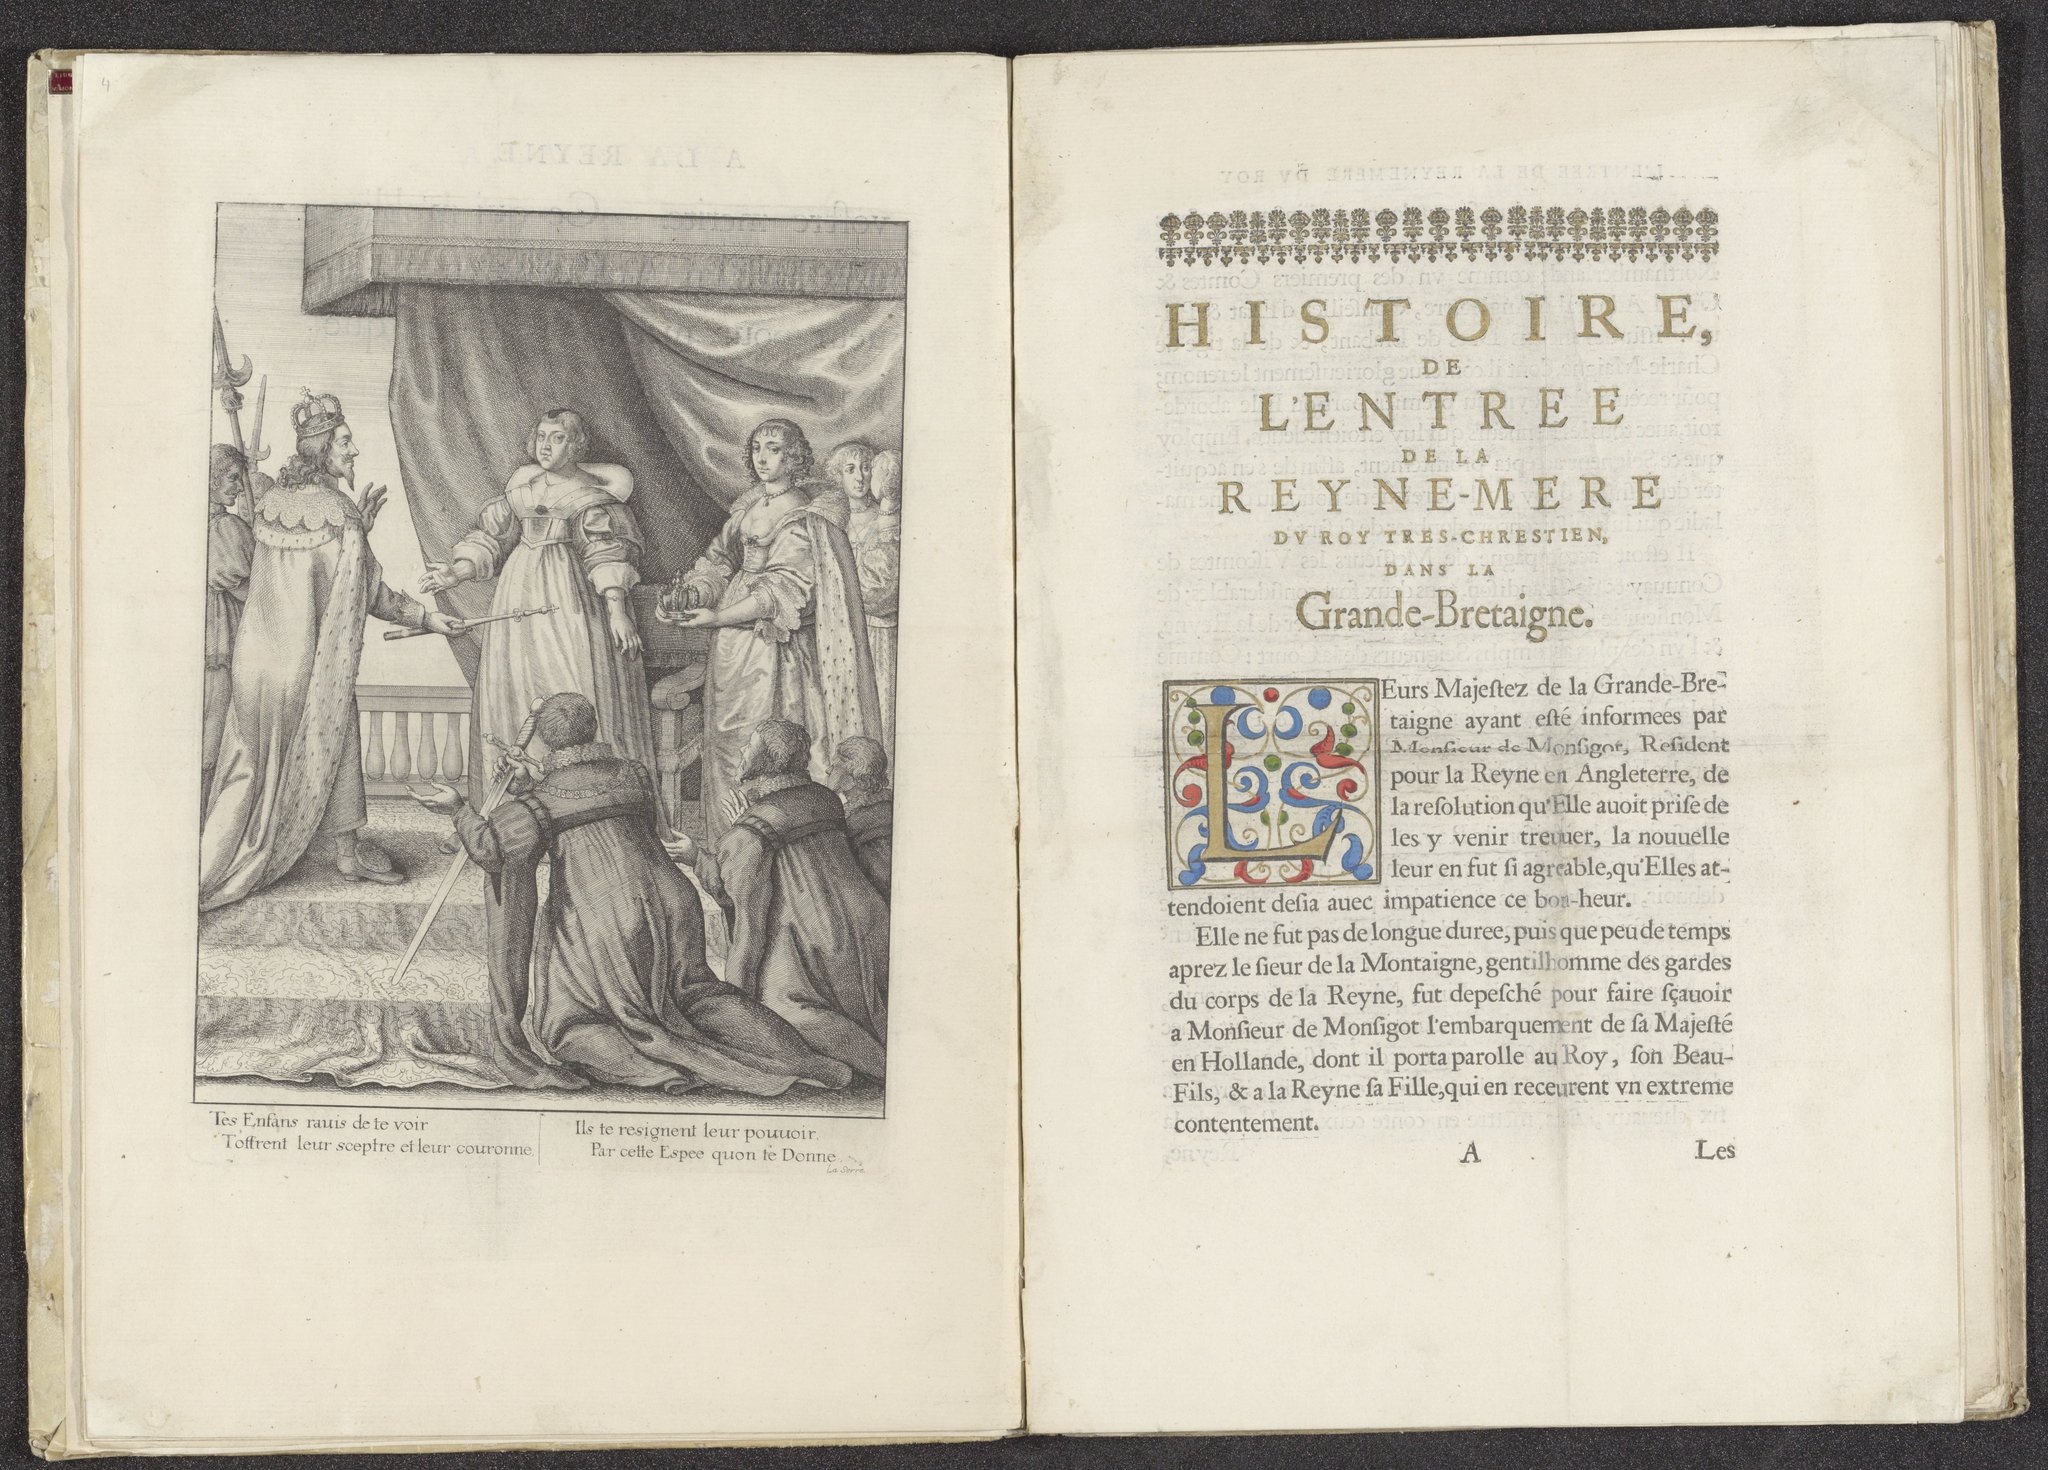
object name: print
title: Maria de' Medici, Karel I en Henrietta Maria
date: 1639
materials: paper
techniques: etching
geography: london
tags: henriëtta maria van frankrijk (koningin van engeland, schotland en ierland), cologne, maria de' medici, london, karel i (koning van engeland)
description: Maria de' Medici staat op een podium en onder een baldakijn. Koning Karel I van Engeland reikt haar zijn scepter aan en zijn vrouw Henrietta Maria haar kroon. Op de voorgrond knielen drie mannen. Eén van hen reikt zijn zwaard aan. In de ondermarge vier regels tekst in twee kolommen, in het Frans. De prent maakt deel uit van een boek over de ontvangst van de Franse koning-moeder Maria de' Medici aan Engeland.